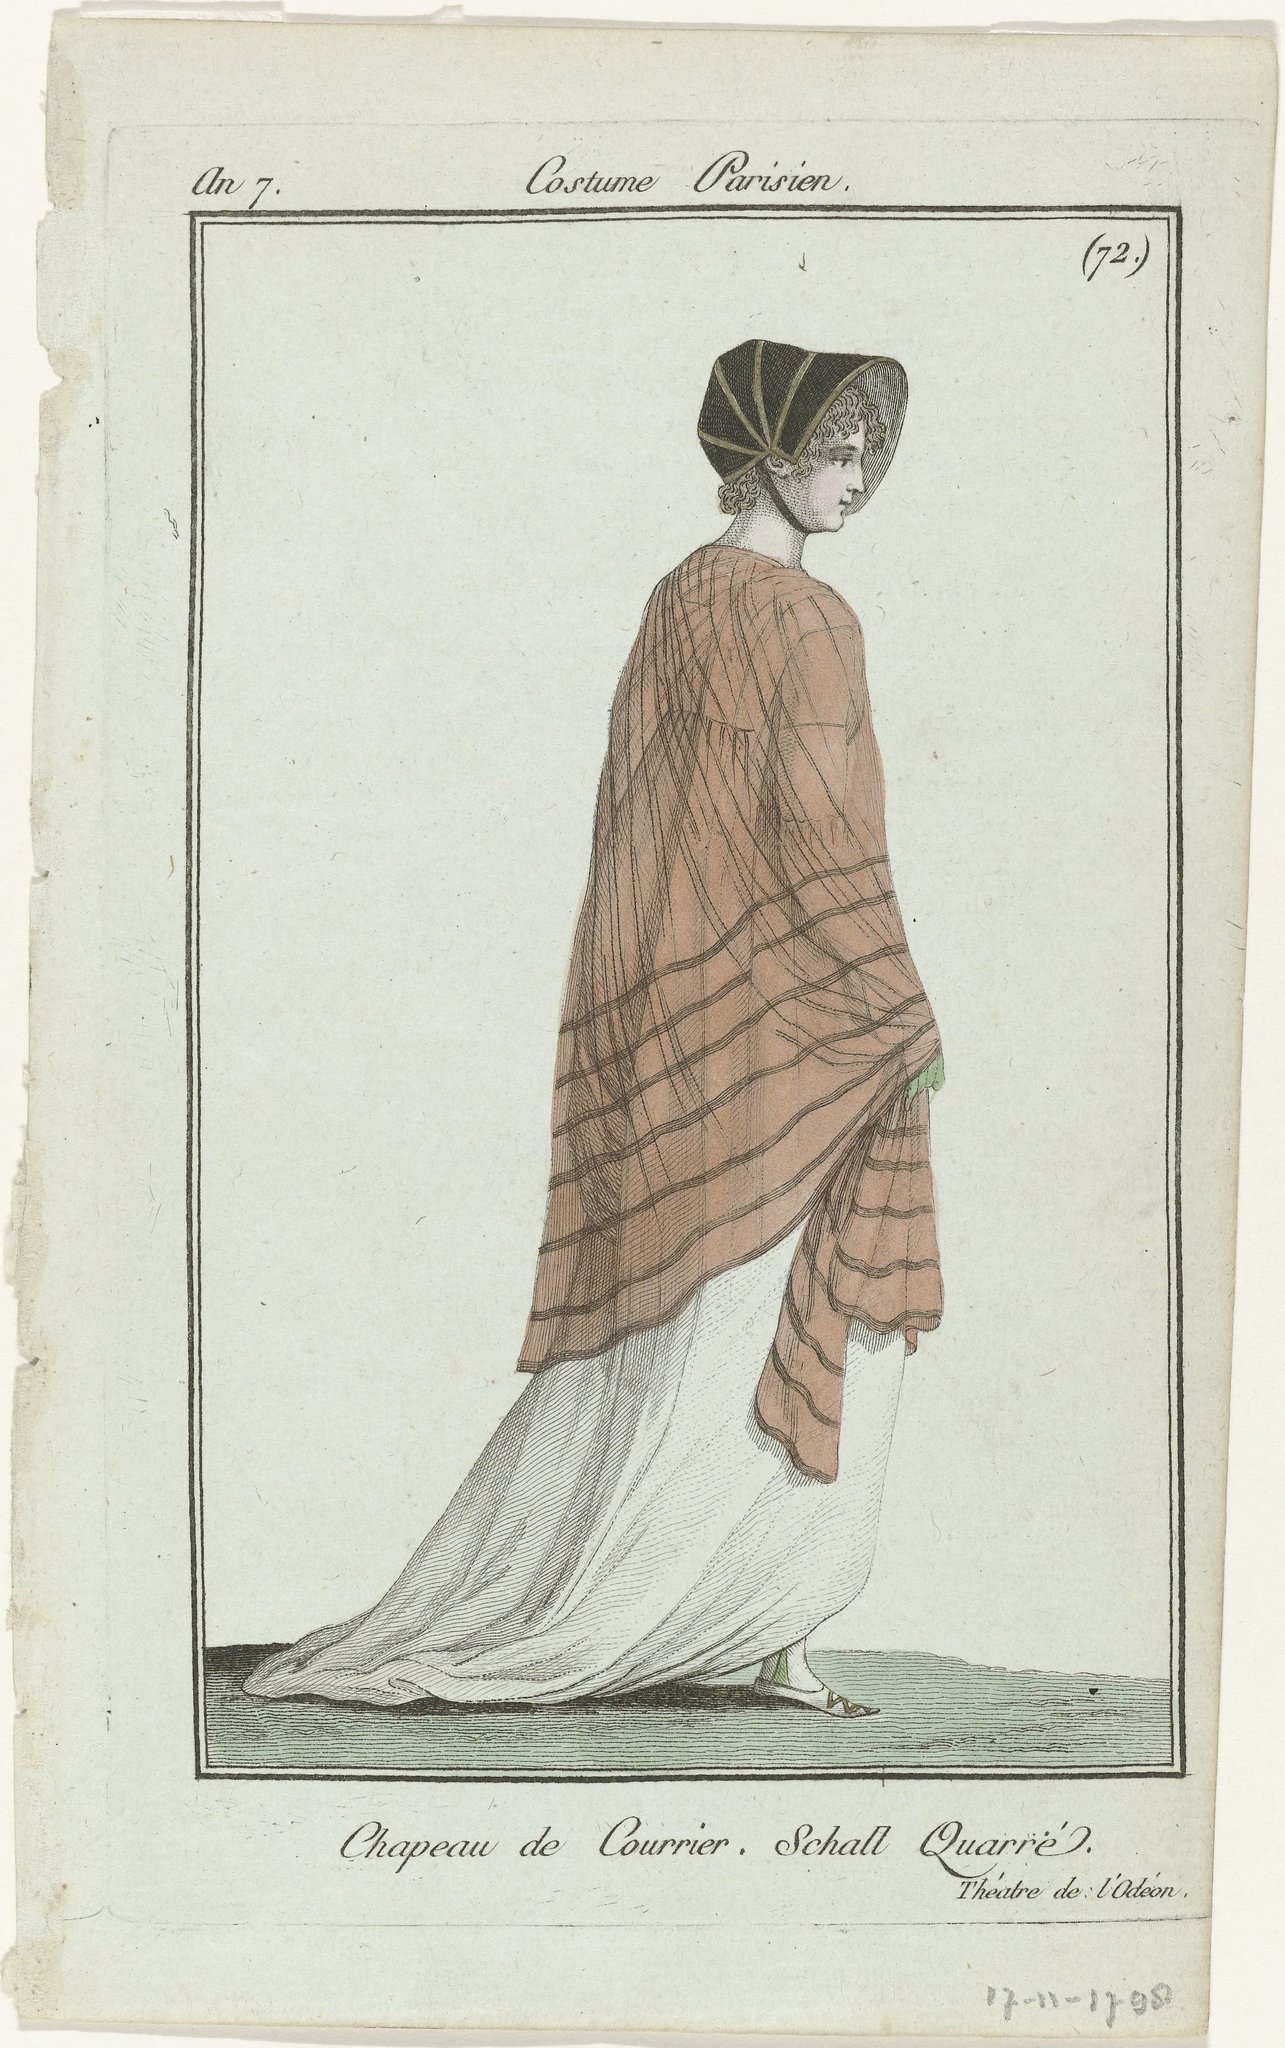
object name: fashion print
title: Journal des Dames et des Modes, Costume Parisien, 7 novembre 1798, An 7, (72) : Chapeau de Courrier (...)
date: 1798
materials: paper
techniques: engraving, hand coloring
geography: paris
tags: gloves, mittens (long gloves) (+ women's clothes), clothing for the upper part of the body (shawl) (+ women's clothes), fashion plates, head-gear: hat (+ women's clothes), shoes, sandals (+ women's clothes), dress, gown (+ women's clothes)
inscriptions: title: ‘Costume Parisien.’, caption: ‘Chapeau de Courrier. Schall Quarré. / Théatre de l'Odéon’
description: Vrouw, lopend naar rechts, op de rug gezien, met op het hoofd een hoed: 'Chapeau de Courrier'. Om de schouders een vierkante sjaal met strepen. Zij draagt een japon met sleep. Verdere accessoires: lange handschoenen, kous, platte schoen met puntige neus. Volgens het onderschrift is deze voorstelling naar het leven getekend bij de 'Théatre de l'Odéon'. De prent maakt deel uit van het modetijdschrift Journal des Dames et des Modes, uitgegeven door Sellèque, Parijs, 1797-1839.